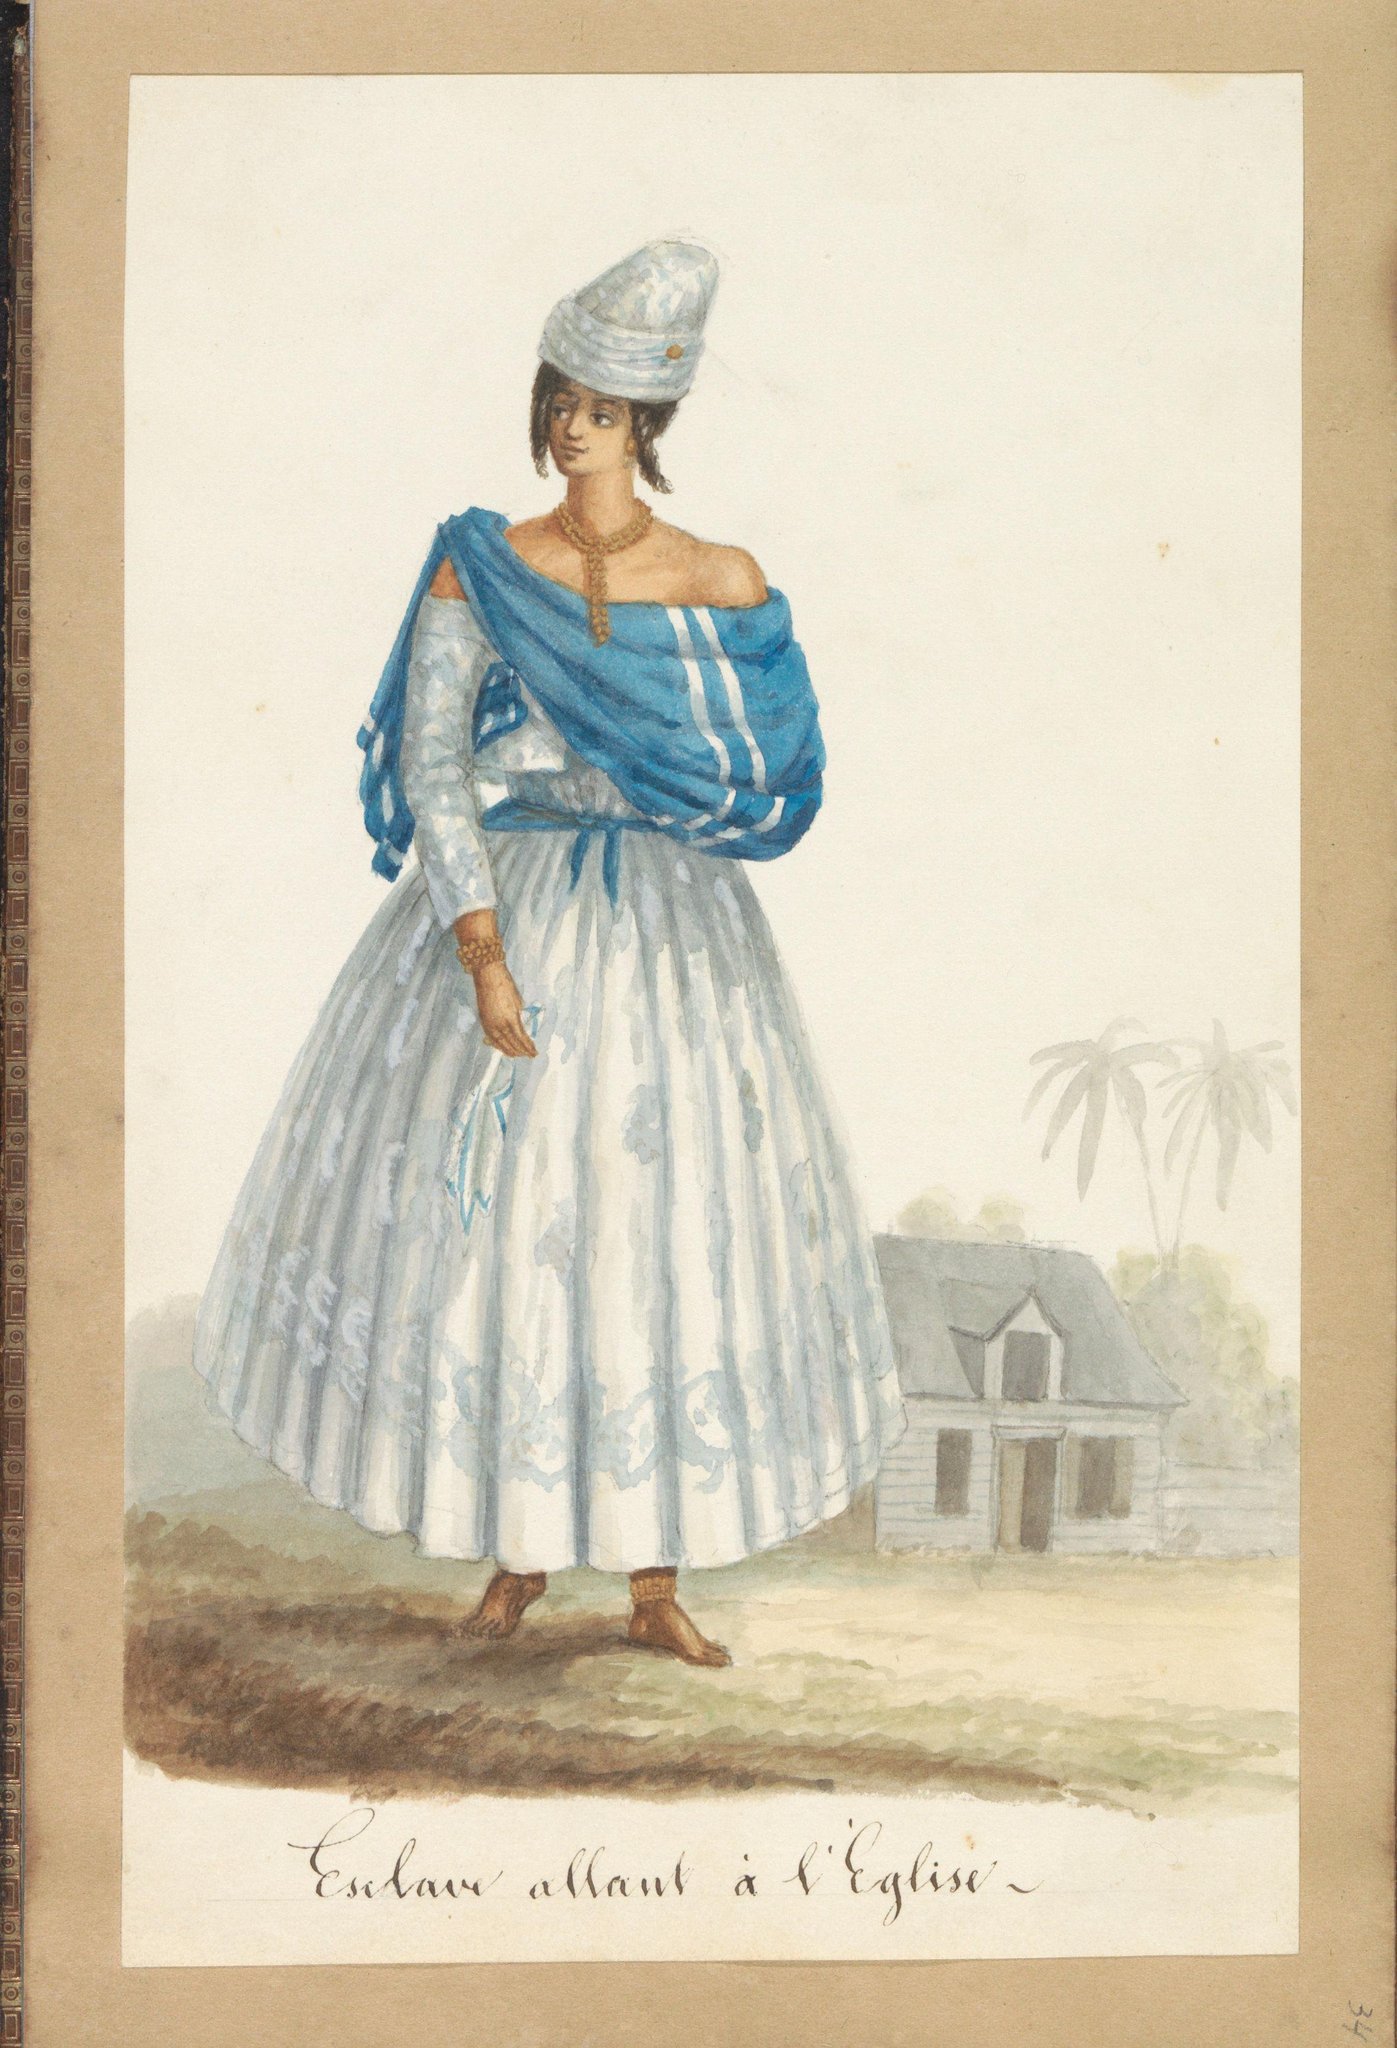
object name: kostuumstudie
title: Album met tekeningen van Suriname, p.34 (50)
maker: jacob marius adriaan martini van geffen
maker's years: 1821-1866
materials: ink, paper, pencil, watercolor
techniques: brush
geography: suriname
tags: master ~ enslaved person, suriname